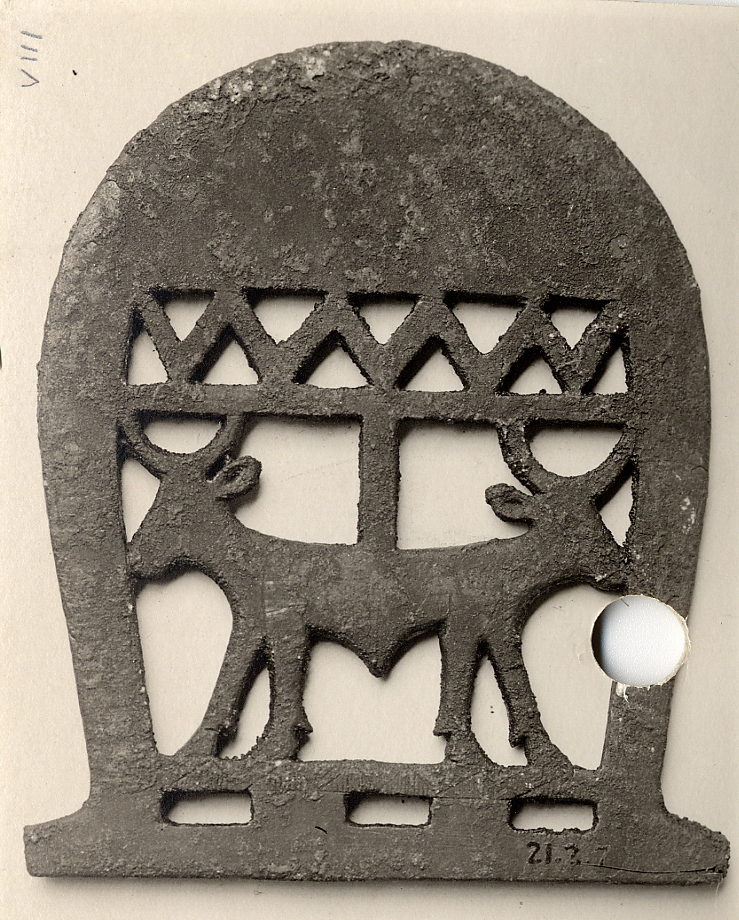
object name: ax head with two bull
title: Ax head with two bulls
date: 1981-1550 BCE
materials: bronze, copper alloy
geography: egypt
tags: bulls